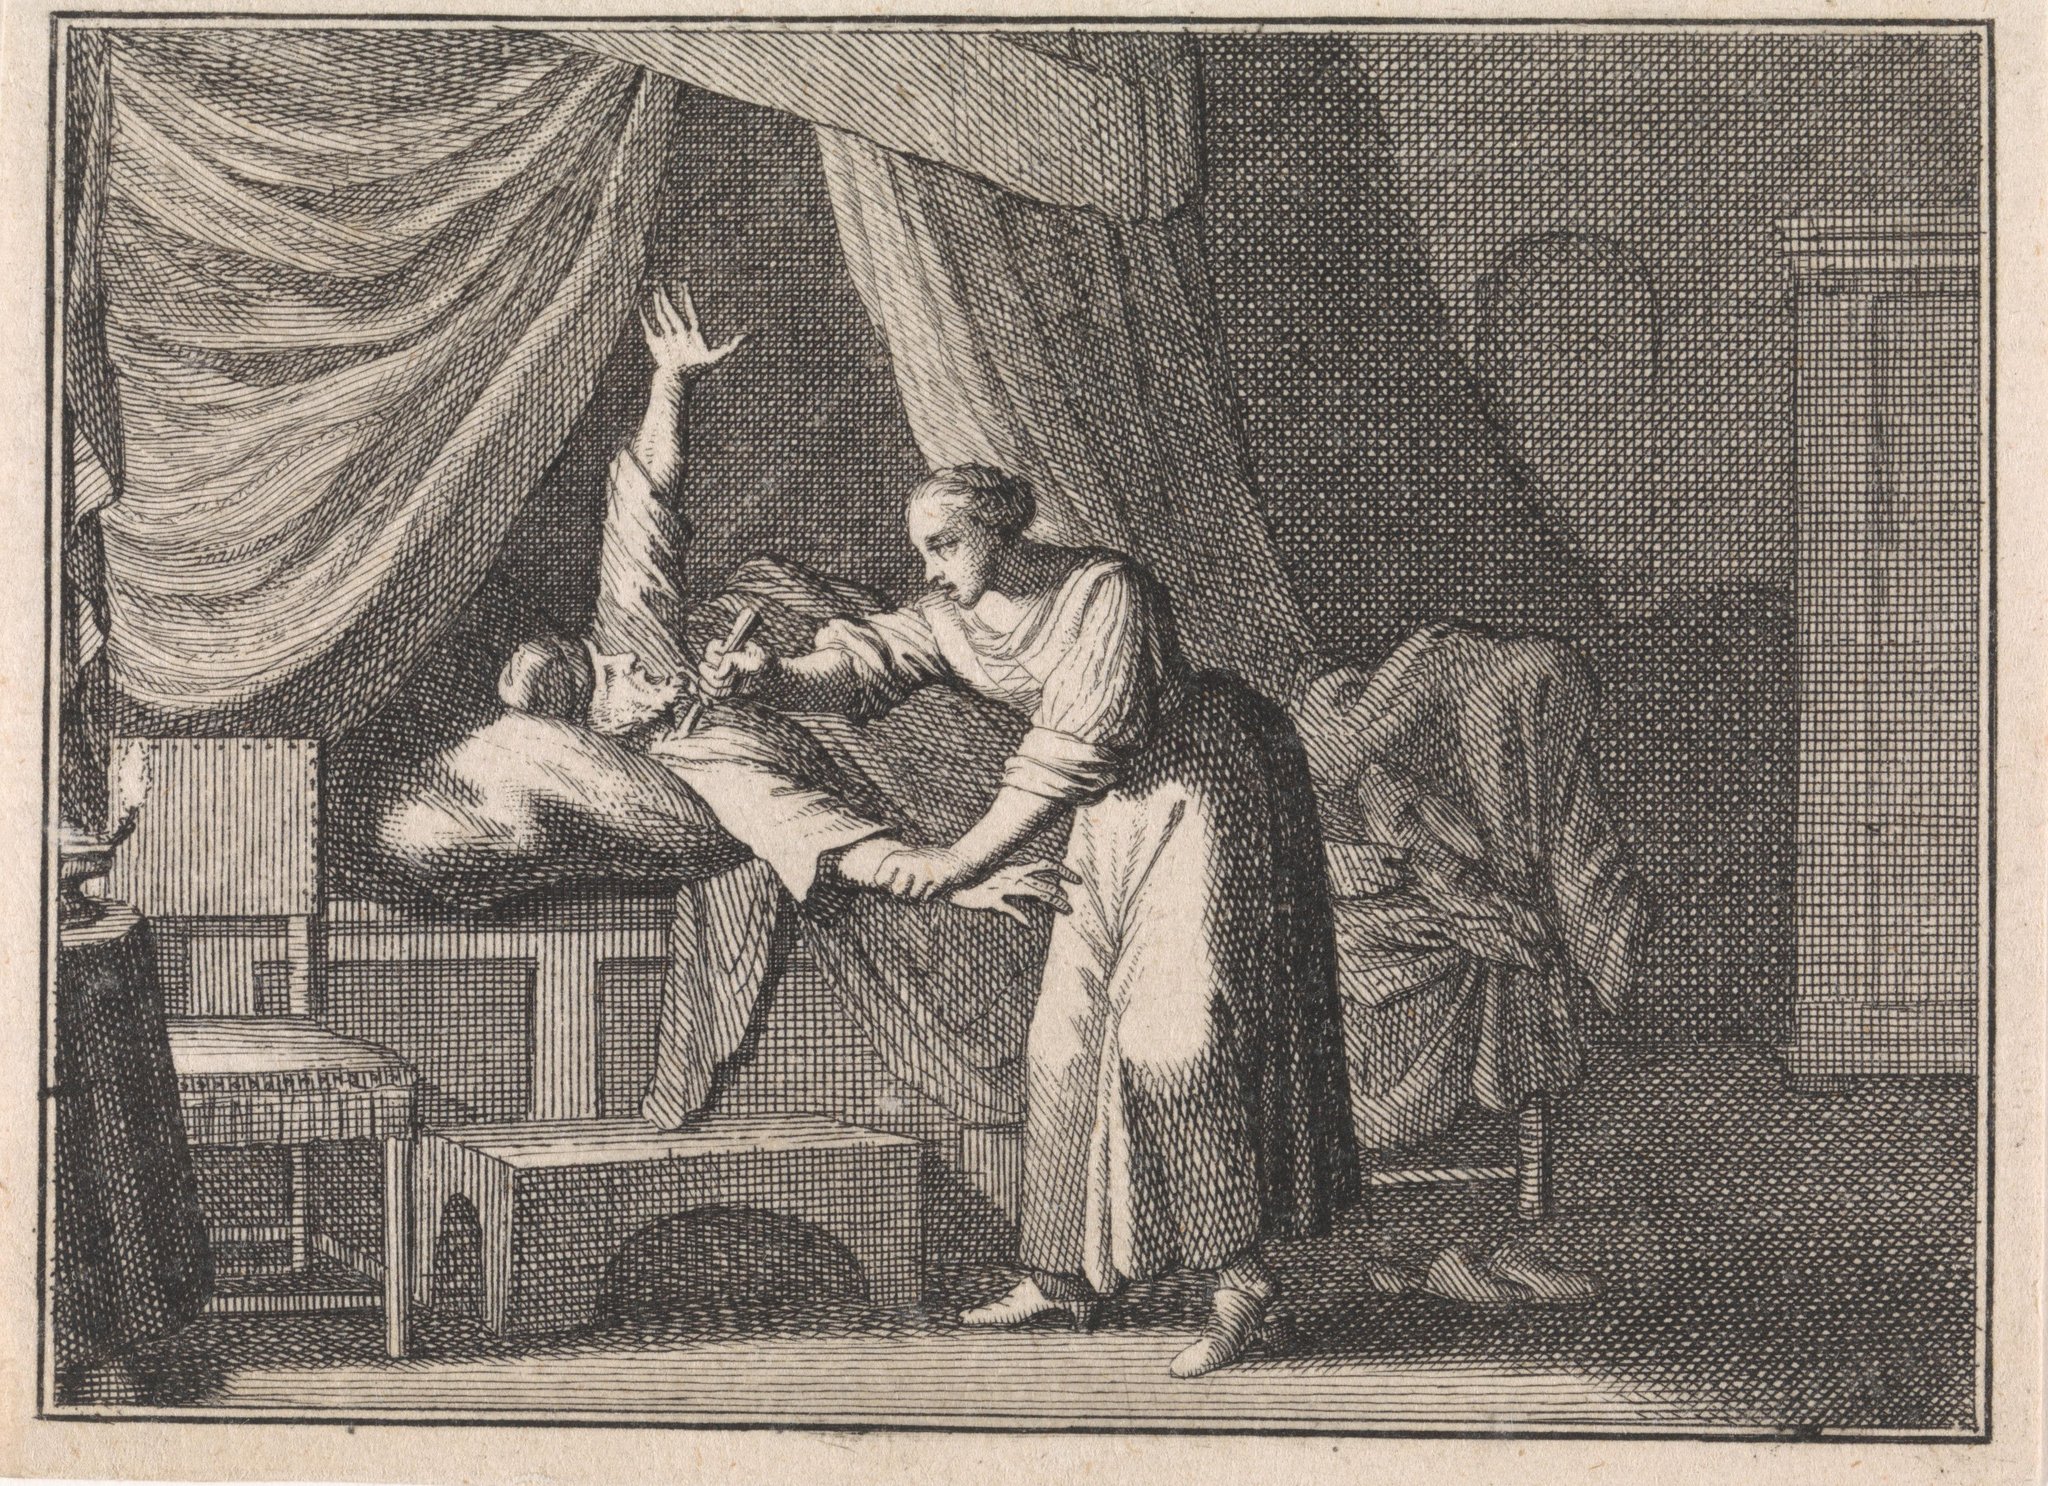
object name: print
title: Dus unverantwortliche von Dem zu Der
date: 1710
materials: paper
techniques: etching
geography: nuremberg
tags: violent death by dagger, knife, violent death, being killed; being mishandled and maltreated; seeking death (+ death by murder)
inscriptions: collector's mark: Lugt 240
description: Illustratie uit: Abraham a Sancta Clara. Heilsames Gemisch Gemasch, das ist: Allerley seltsame und verwunderliche Geschichten (...). Neurenberg: Christoph Weigel, 1710, p. 430.